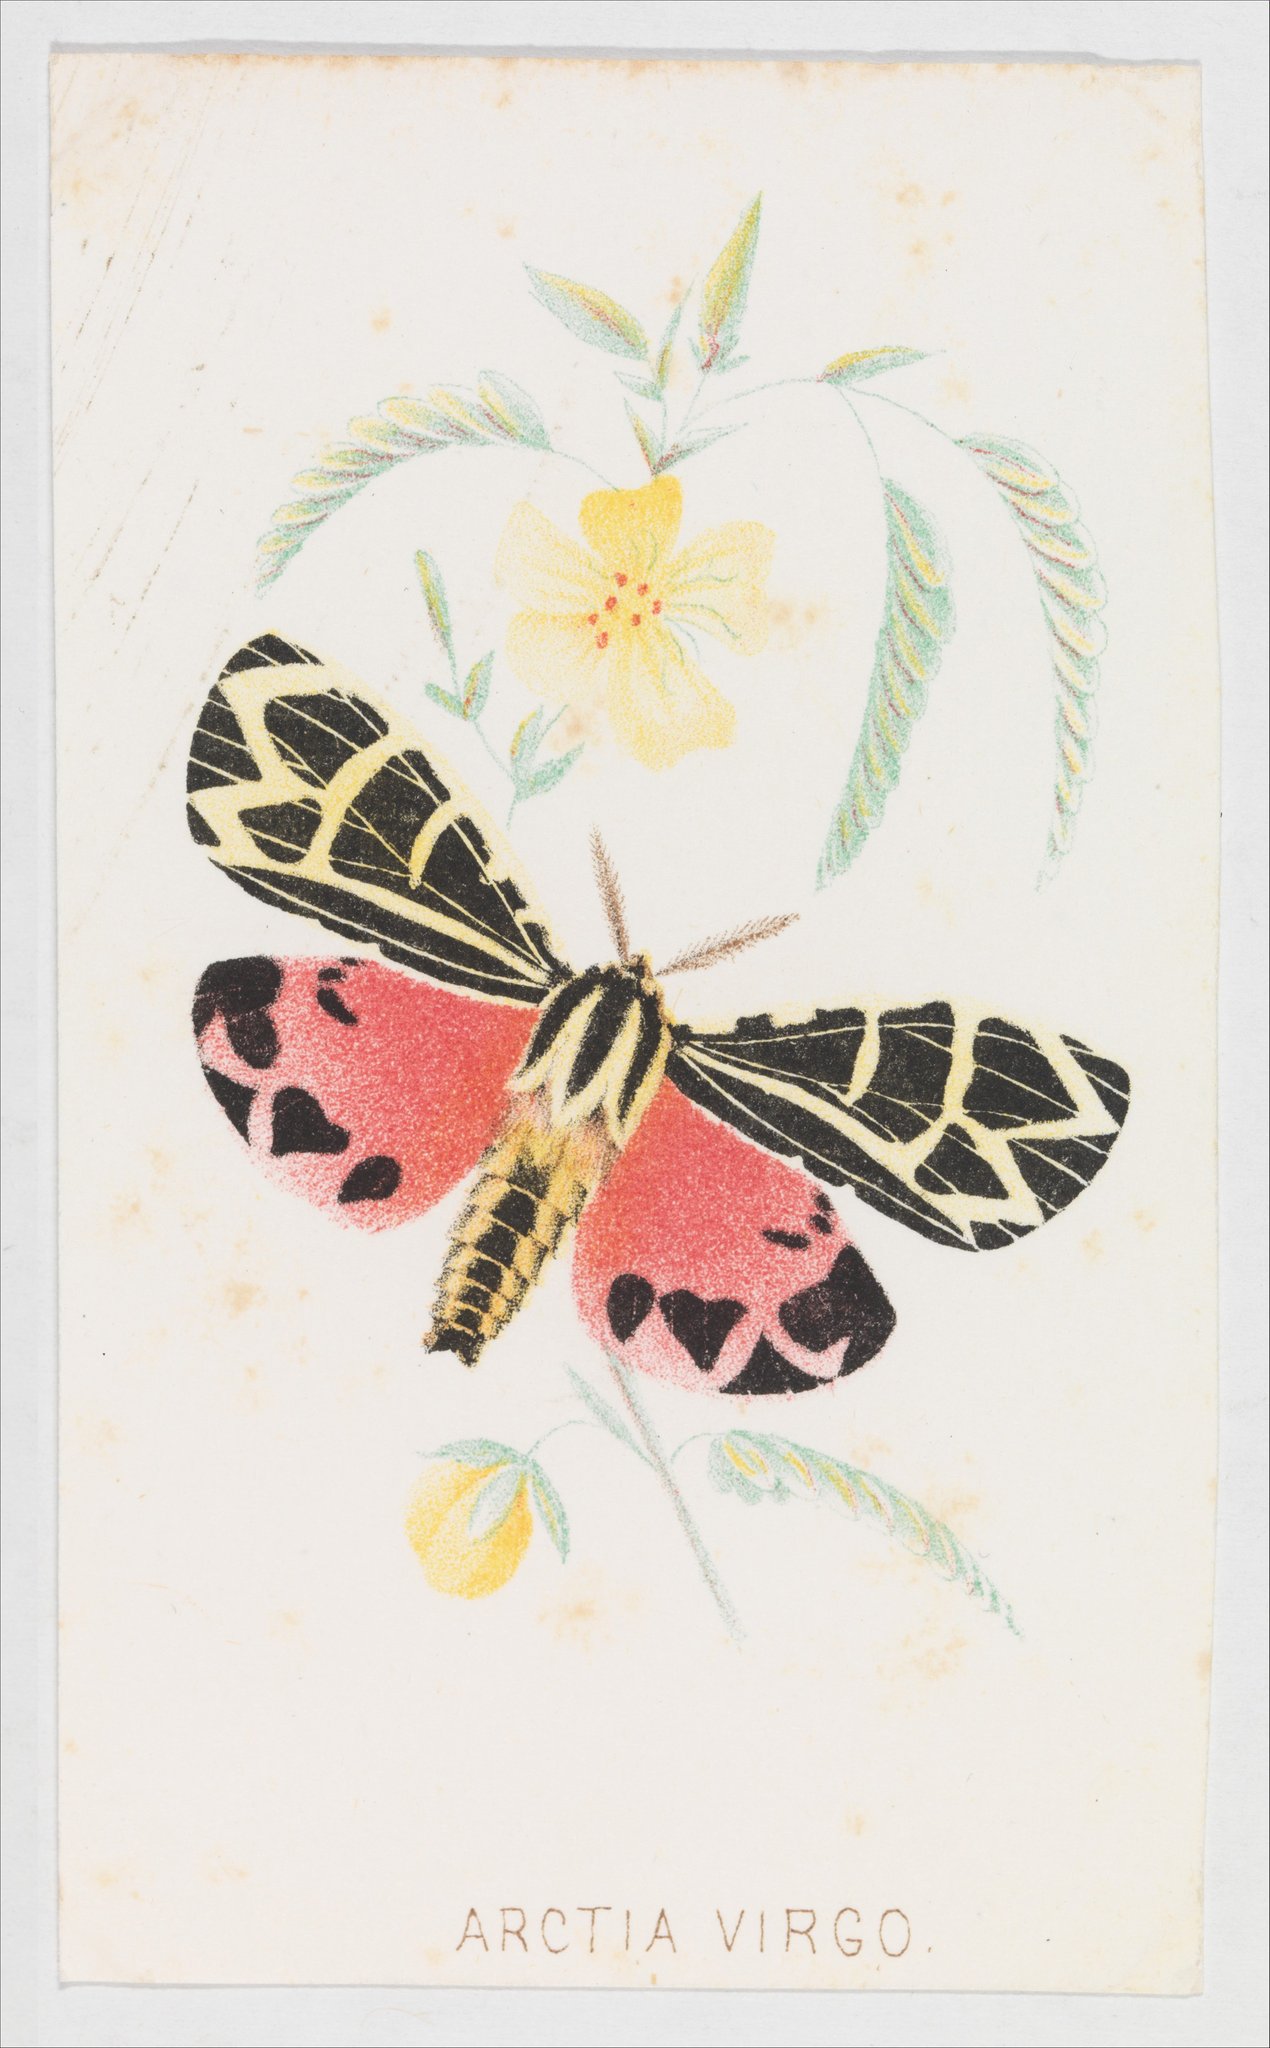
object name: print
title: Arctia Virgo from The Butterflies and Moths of America Part 5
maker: louis prang & co.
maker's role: publisher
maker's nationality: american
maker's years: 1800-1950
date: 1862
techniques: lithograph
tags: butterflies,flowers